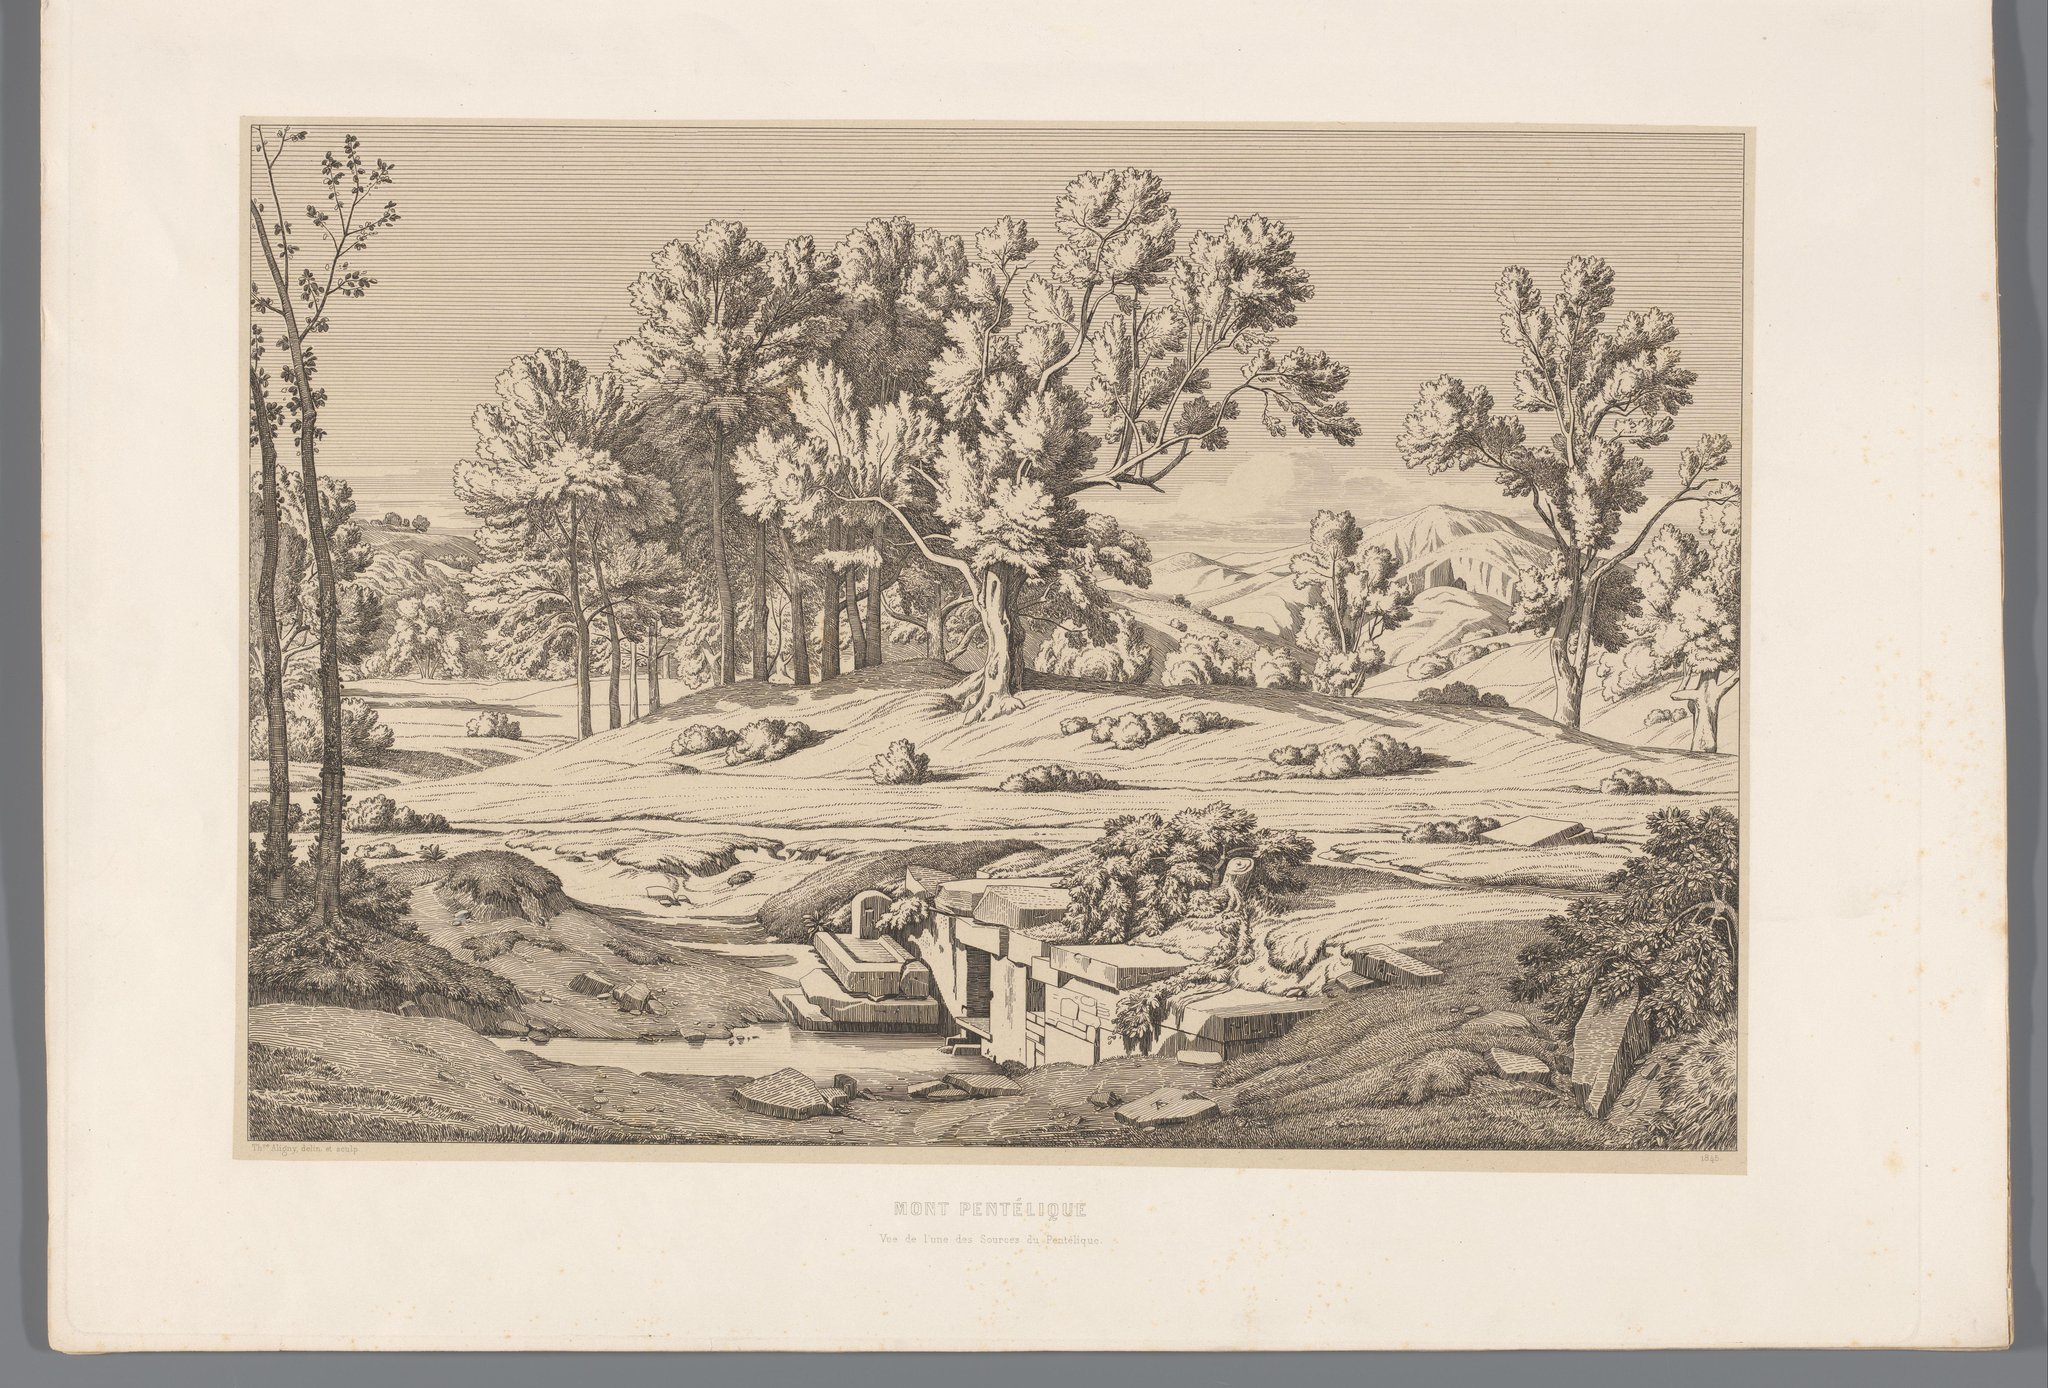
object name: print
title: Mont Pentélique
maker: claude-félix-théodore caruelle d aligny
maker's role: print maker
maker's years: 1798-1871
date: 1845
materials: paper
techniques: etching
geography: france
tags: landscape with ruins, mountains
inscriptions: collector's mark: Lugt 2760, collector's mark: Lugt 2228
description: Maakt deel uit van een omslag met tien prenten.